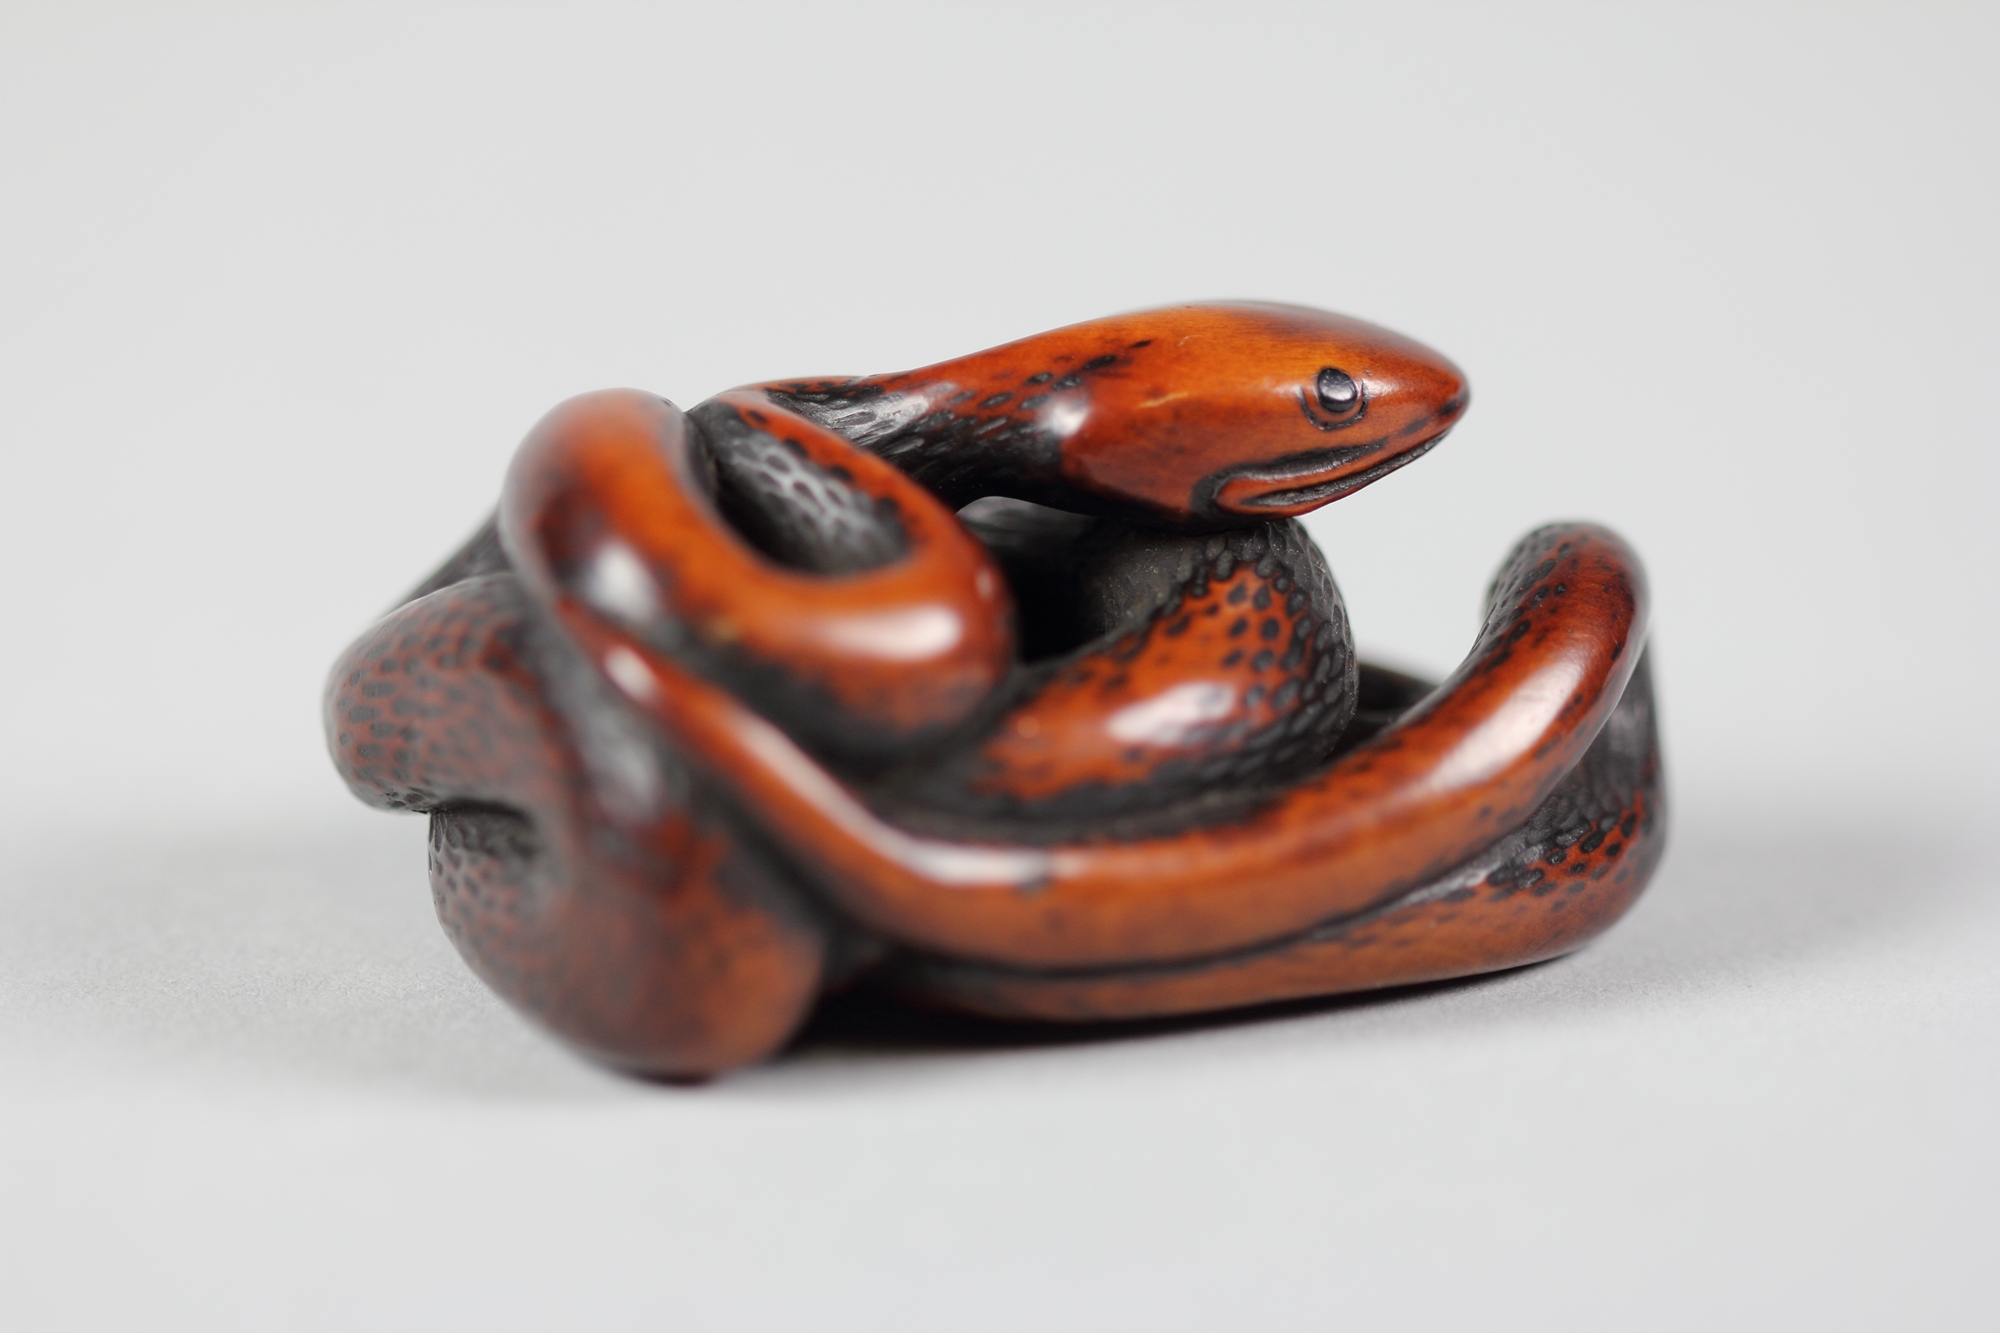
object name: netsuke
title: Netsuke of Snake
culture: japanese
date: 1801-1900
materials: wood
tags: snakes